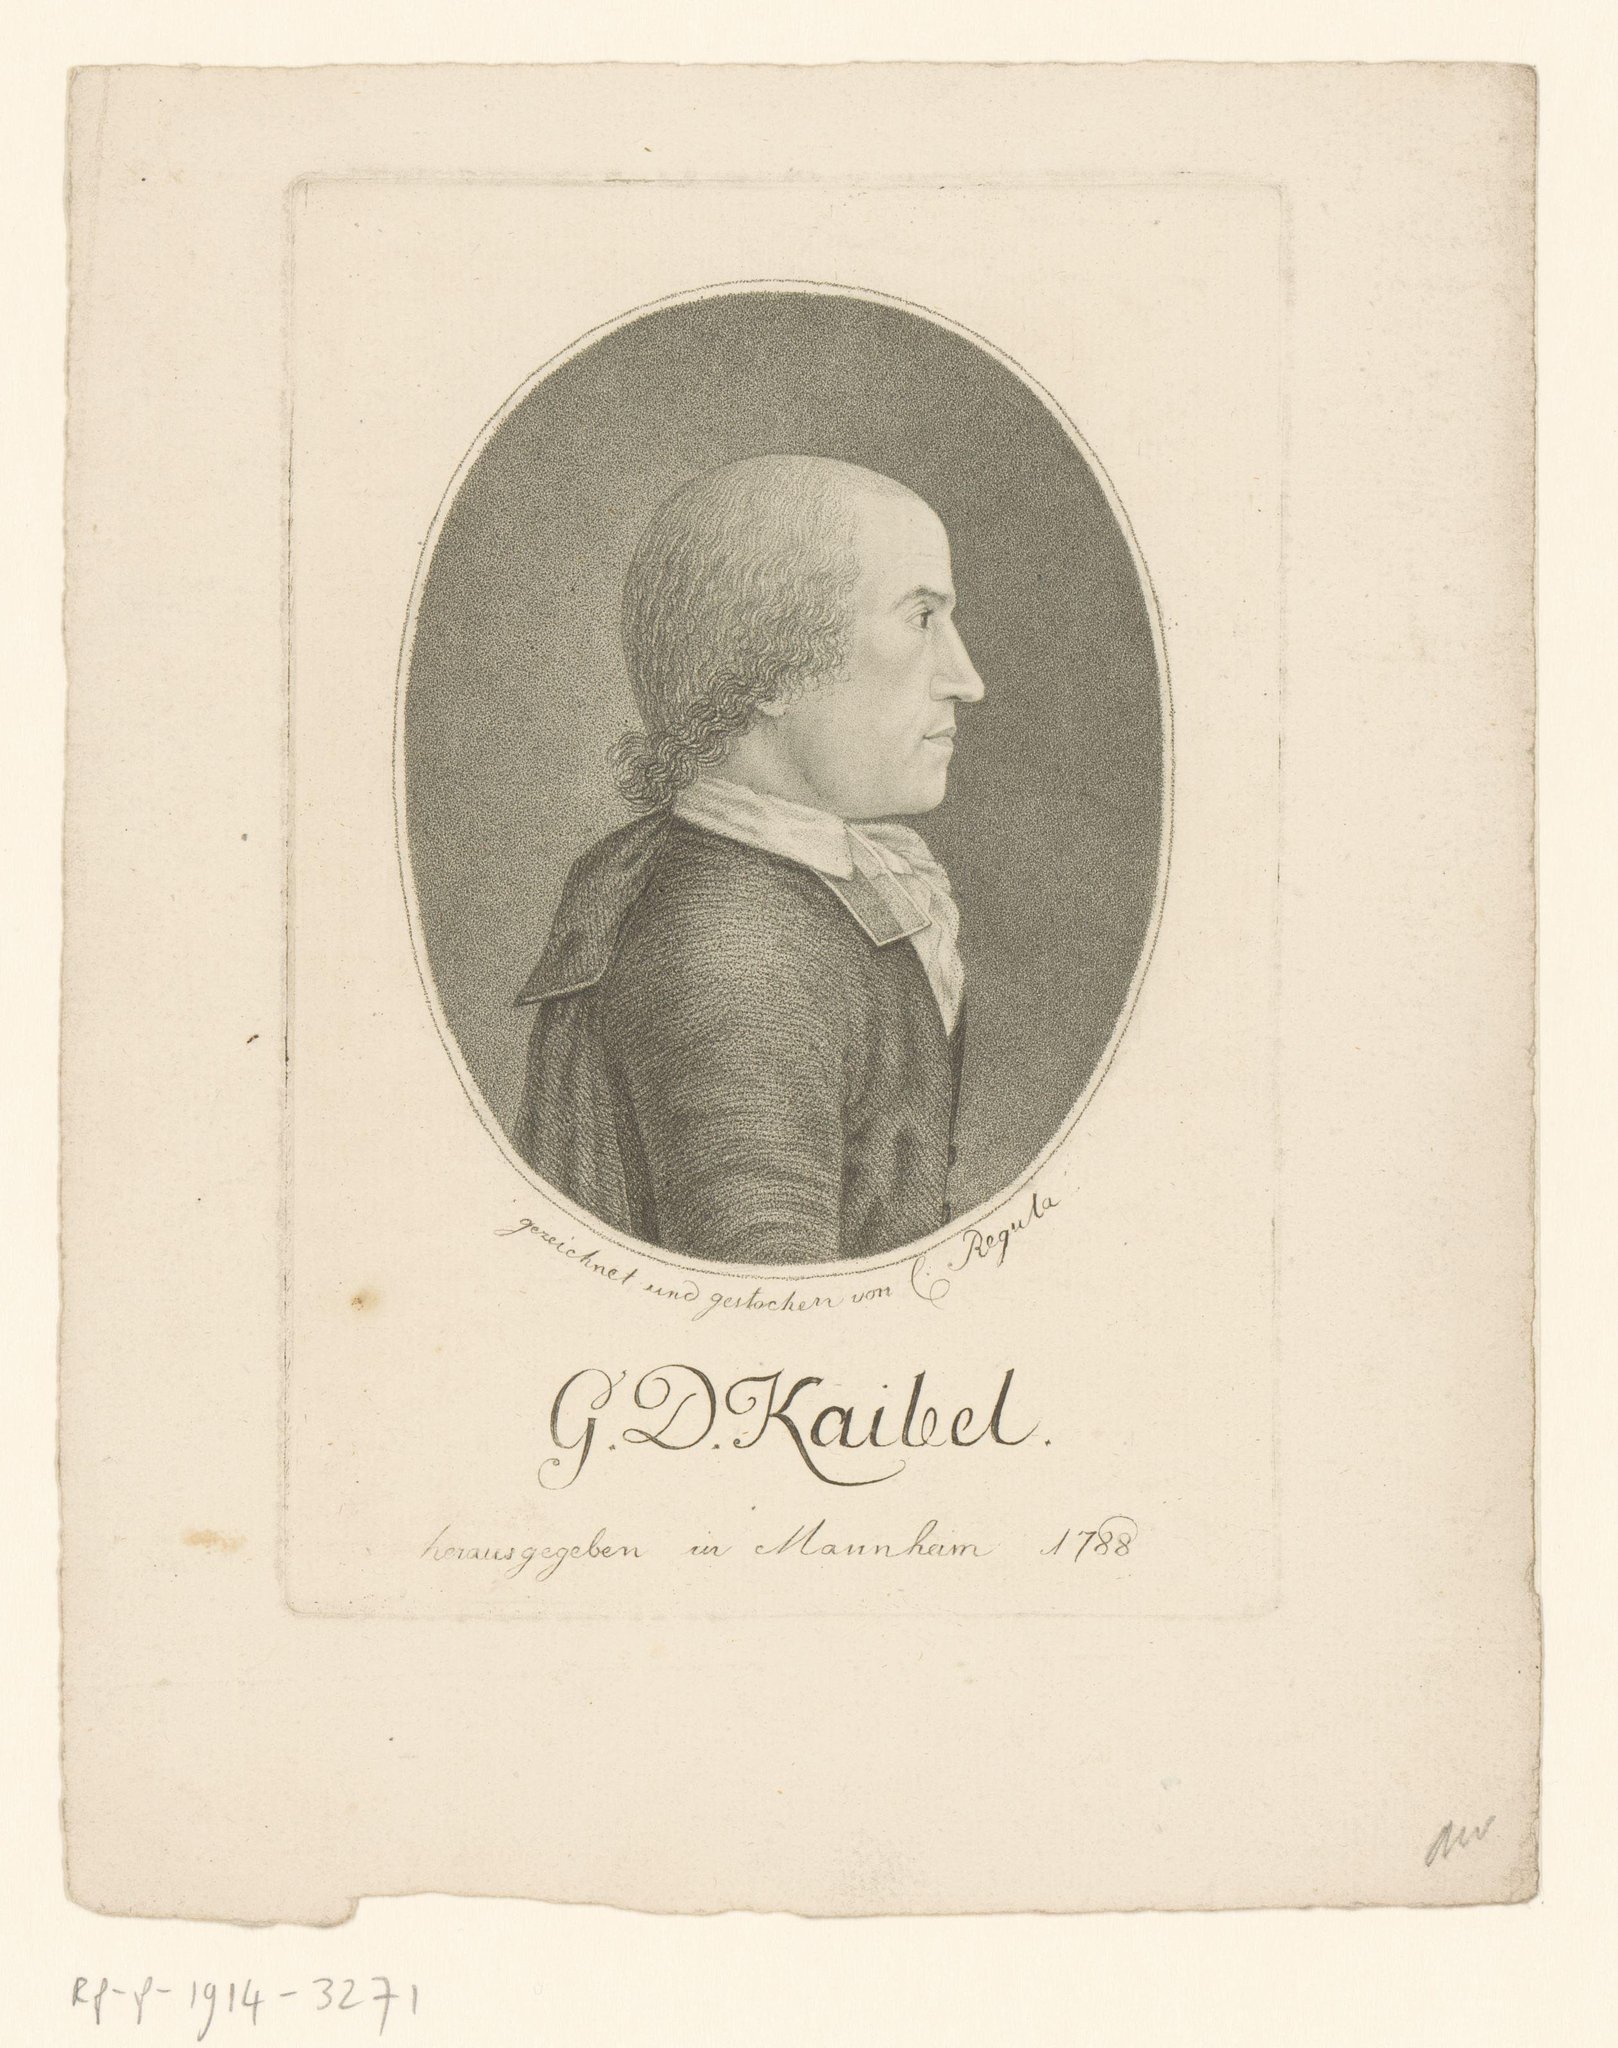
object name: print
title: Portret van Georg David Kaibel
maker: c. regula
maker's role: print maker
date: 1788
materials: paper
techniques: engraving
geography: mannheim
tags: historical persons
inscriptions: collector's mark: Lugt 2228